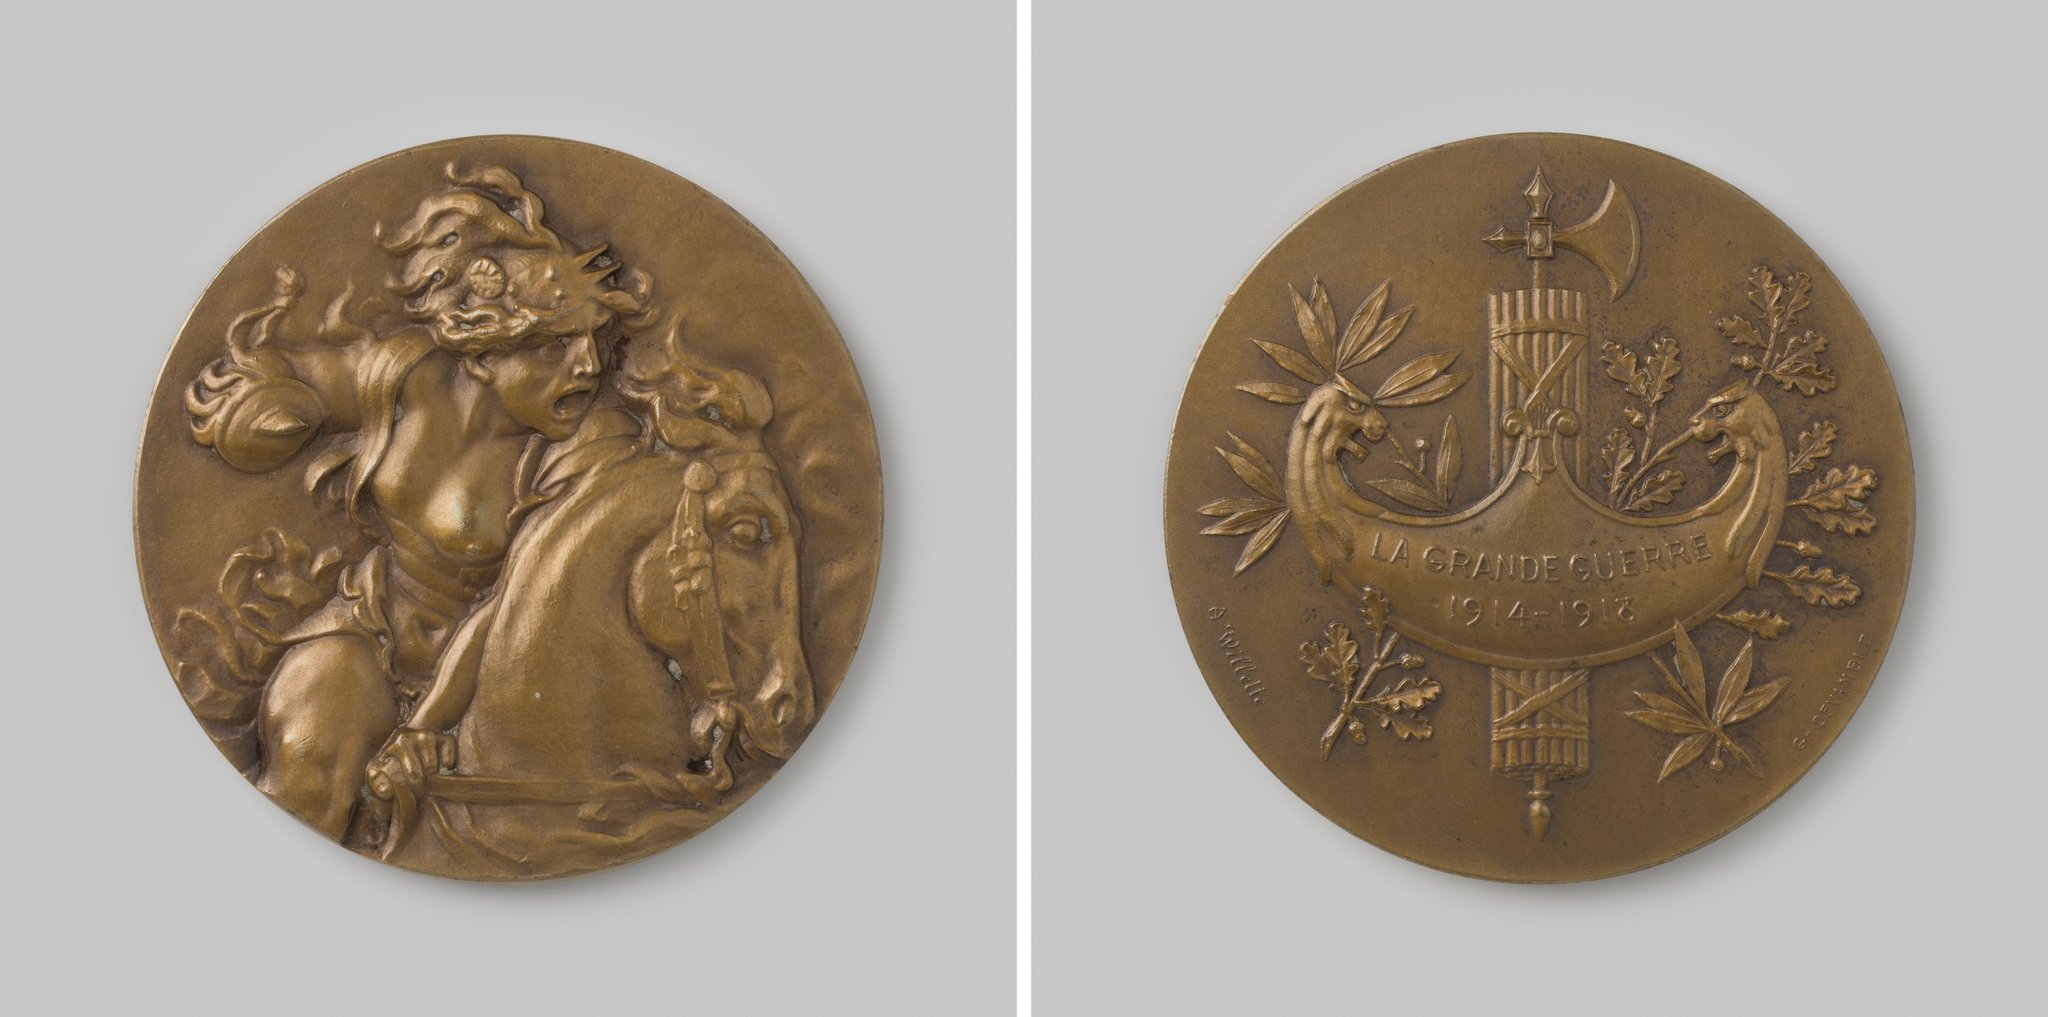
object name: history medal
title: La Grande Guerre 1914-1918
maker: adolphe léon willette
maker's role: print maker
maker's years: 1857-1926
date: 1918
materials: bronze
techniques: striking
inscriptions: hallmark: ‘(driehoekig merk) BRONZE’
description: Bronzen penning, op de voorzijde een aanstormende Amazone te paard met getrokken zwaard, op de keerzijde een bijlvormig bord waarachter een fasces en gekruiste lauwer- en eikentakken.